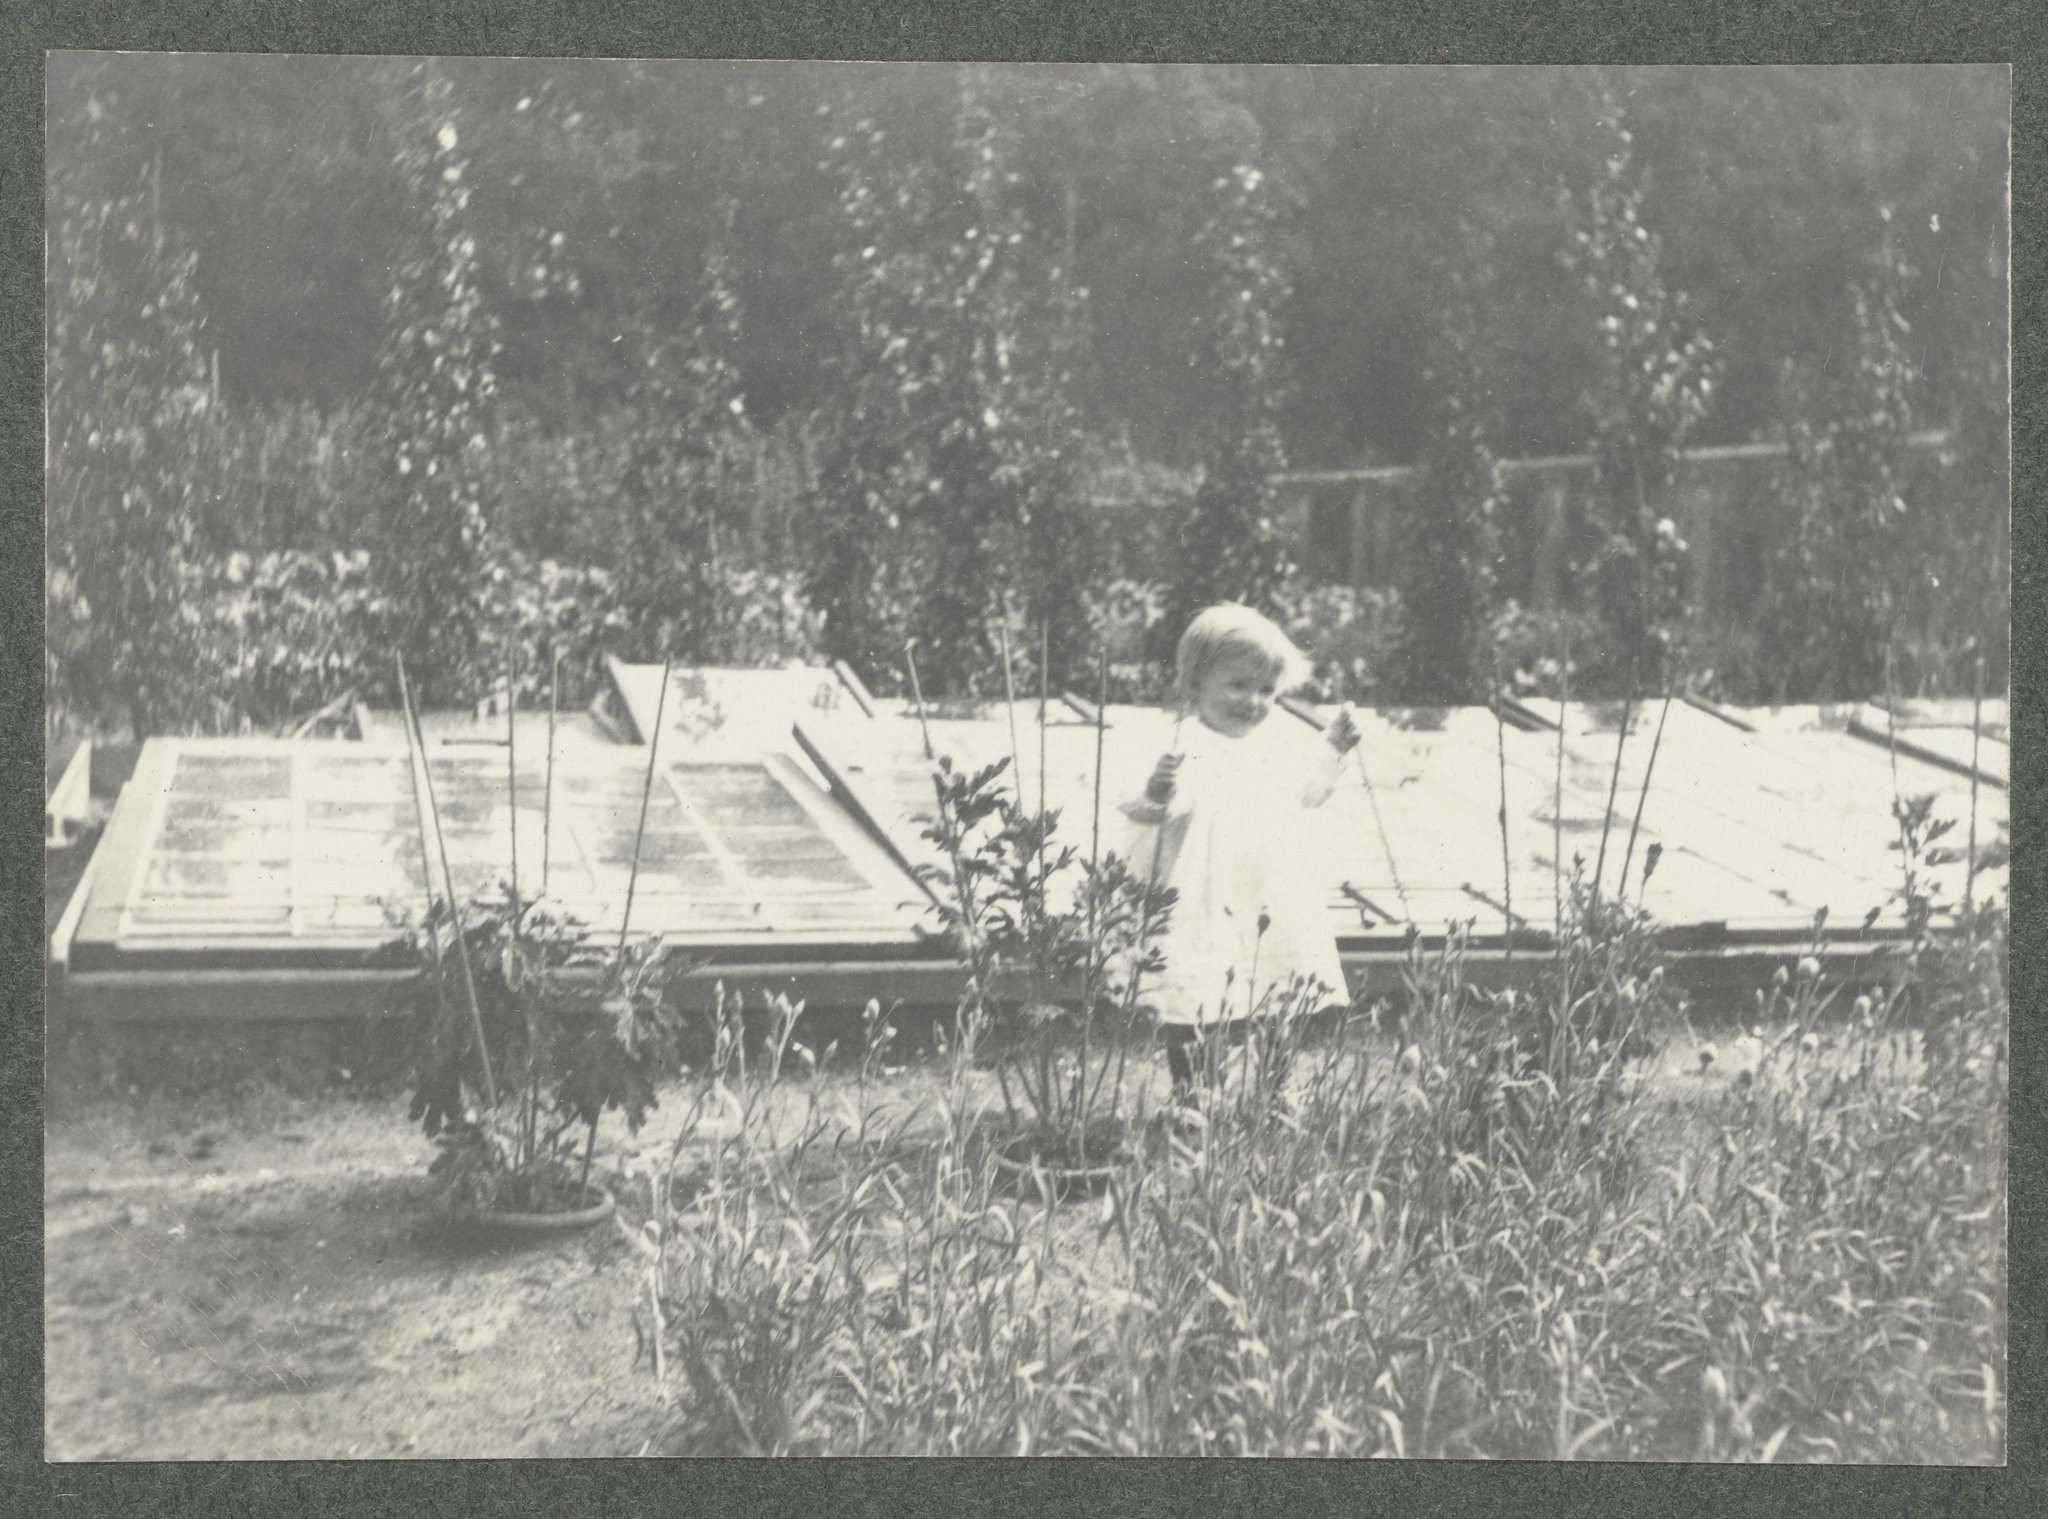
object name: photograph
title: Klein meisje voor plantenkassen in de tuin van landgoed Pauw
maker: geldolph adriaan kessler (dolph)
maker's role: fotograaf, industrieel, voetballer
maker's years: 1884-1945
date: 1913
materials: paper, photographic support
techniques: photography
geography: netherlands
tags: huize de paauw